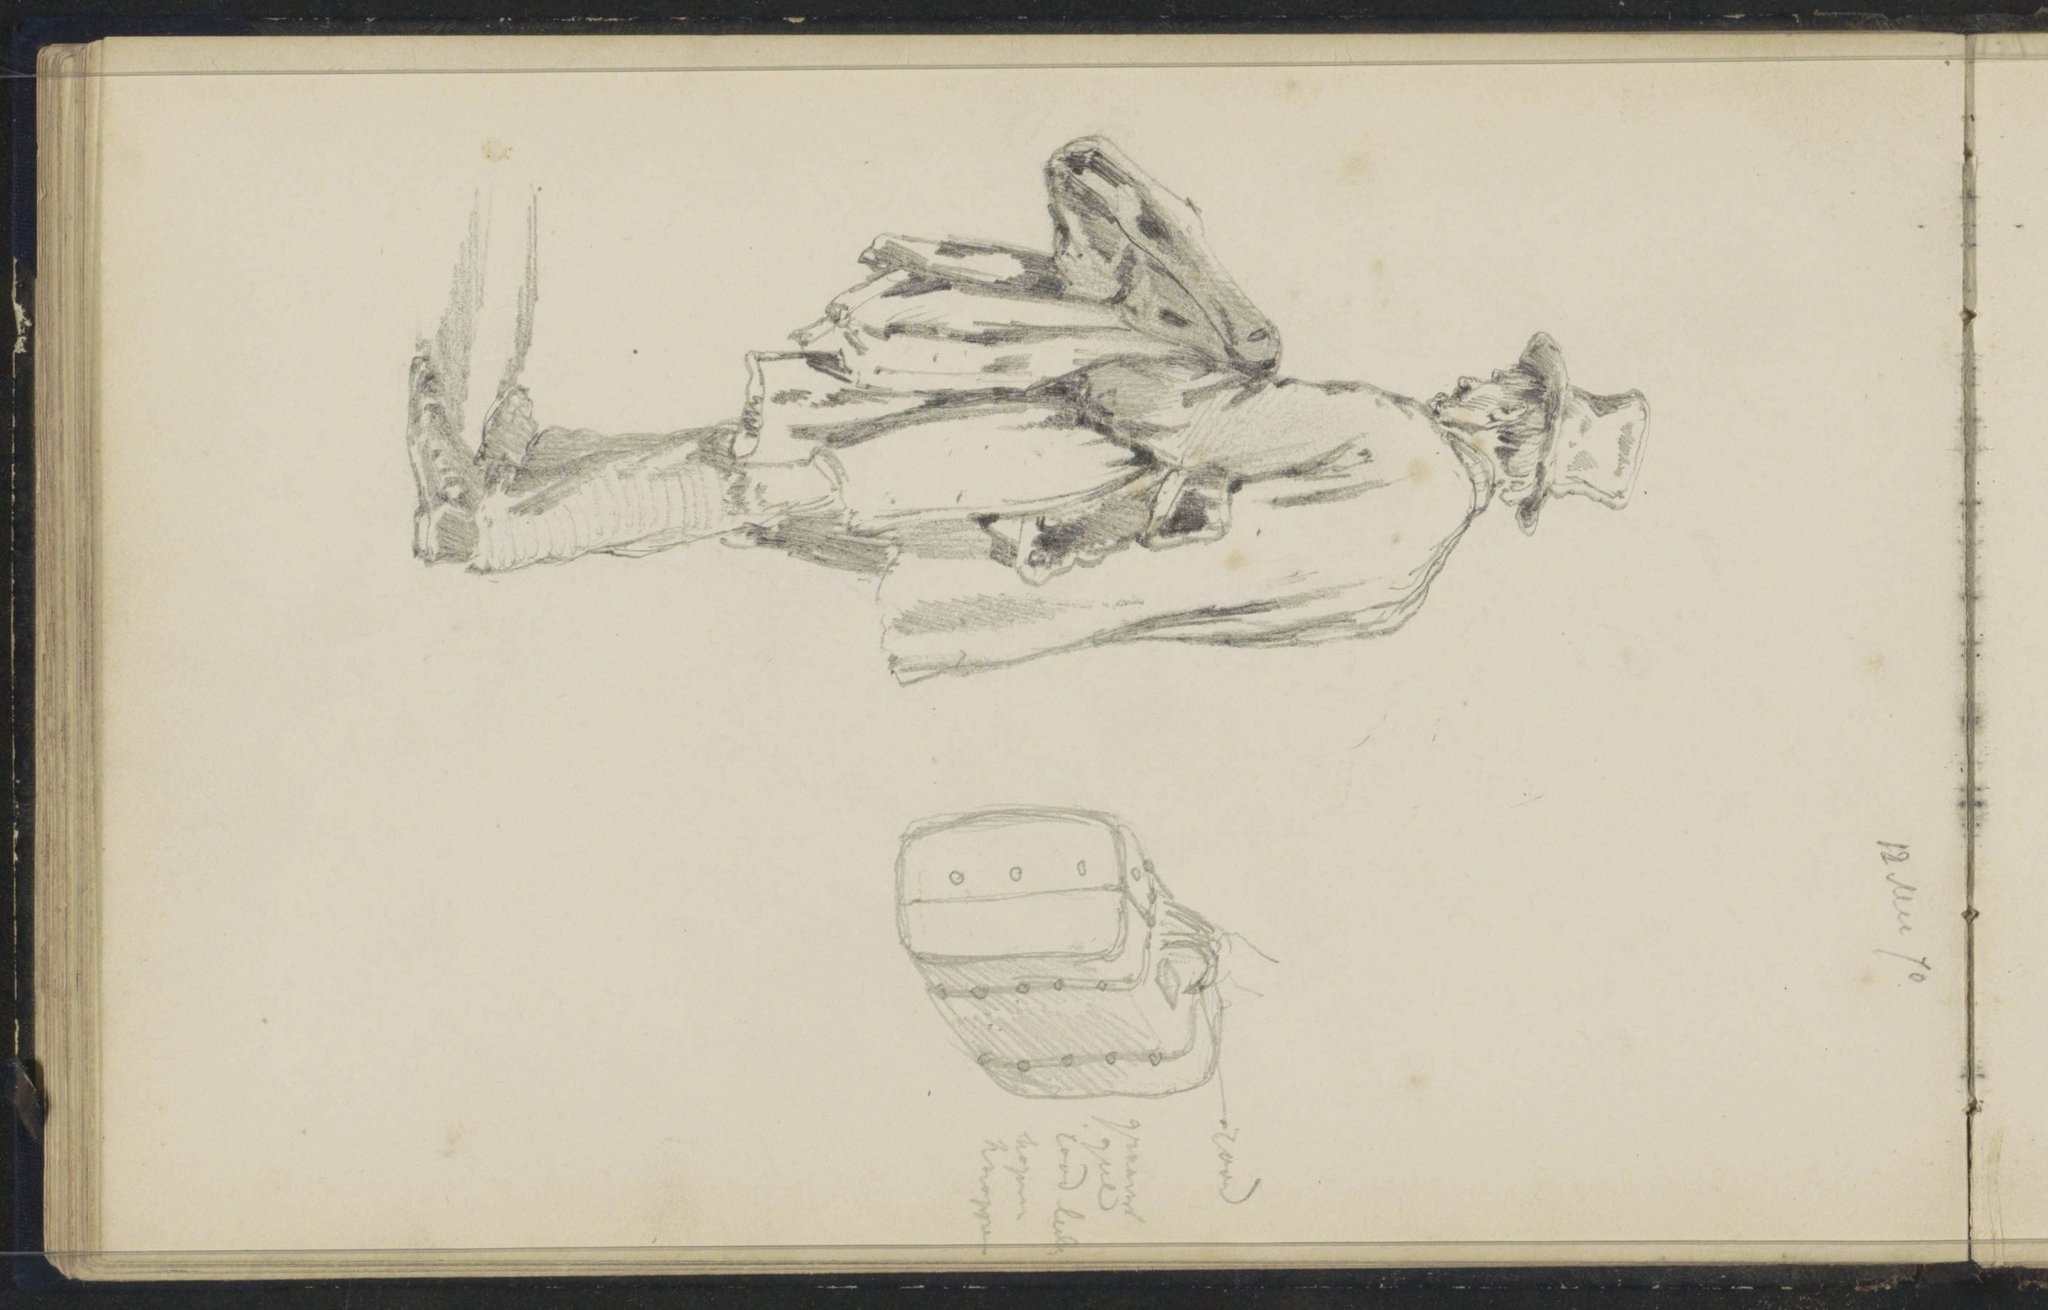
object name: sketchbook leaf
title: Koffer en een man met een jas over zijn arm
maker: cornelis springer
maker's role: draughtsman, painter, print maker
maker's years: 1817-1891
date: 1870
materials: paper, pencil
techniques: stumping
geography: netherlands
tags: coat (+ men's clothes), adult man, head-gear: hat (+ men's clothes), trunk, suit-case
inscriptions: annotation, date: ‘12 Mei 70’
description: Links een man met een hoed en een jas over zijn arm. Rechts een koffer. Blad 17 verso uit een schetsboek met 40 bladen, vervaardigd in Woerden en Gouda.